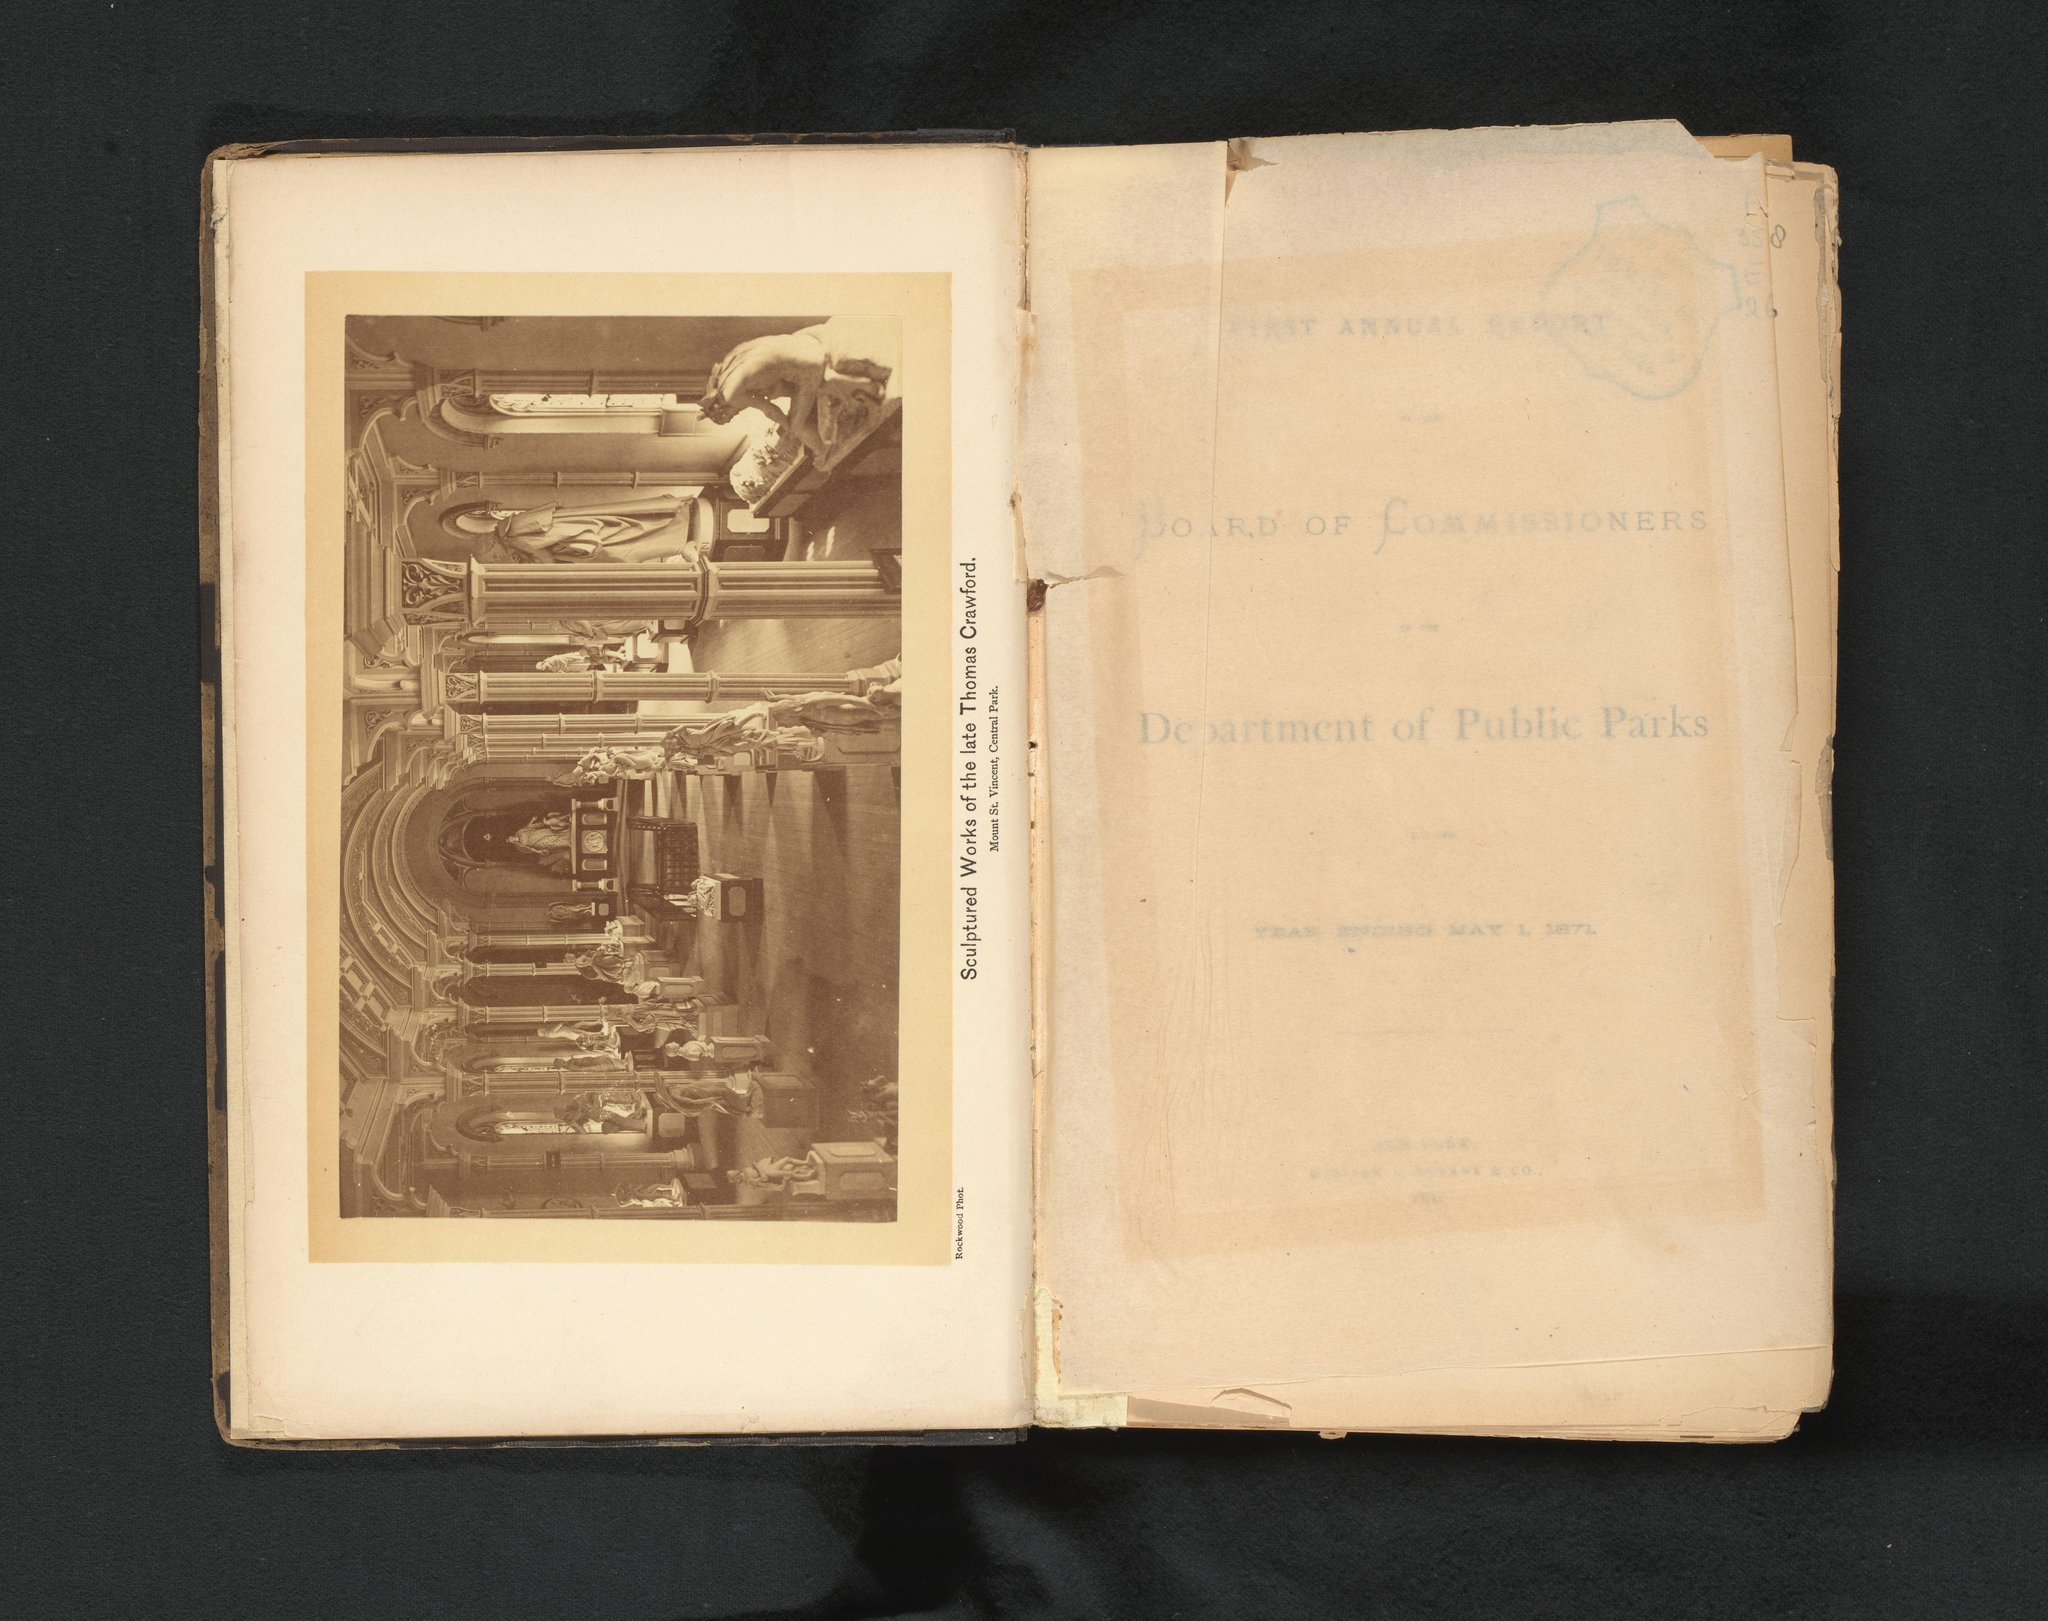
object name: page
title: Sculptured works of the late Thomas Crawford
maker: george gardner rockwood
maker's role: fotograaf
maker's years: 1832-1911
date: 1866-1871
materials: photographic support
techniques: albumen print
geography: central park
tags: gallery of sculptures, sculpture